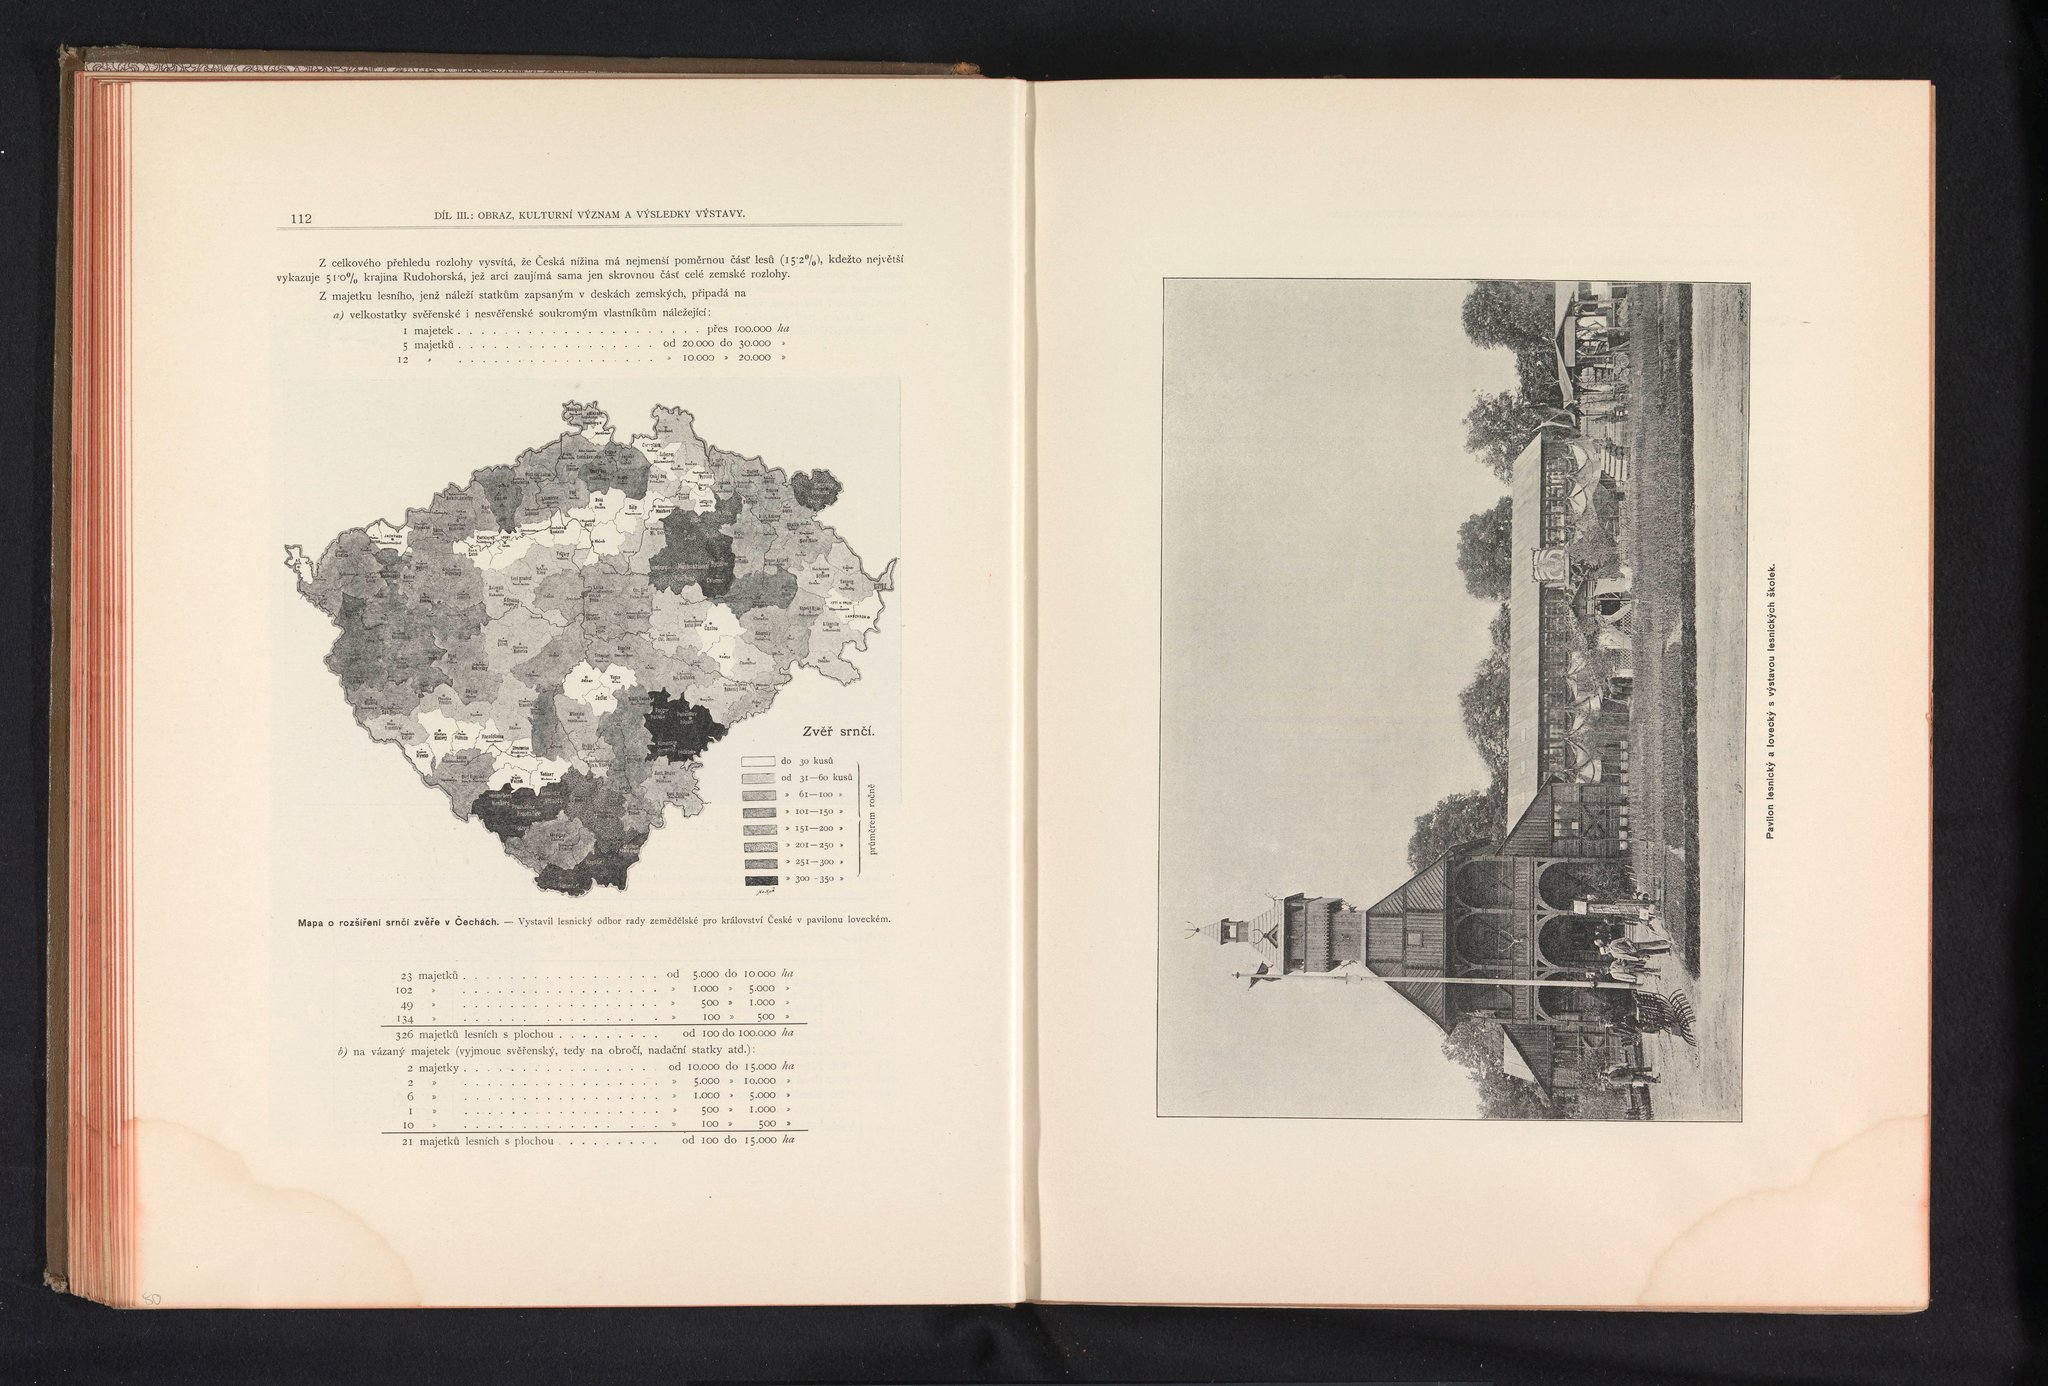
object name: page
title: Pavilon lesnický a lovecký s výstavou lesnických skolek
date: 1891-1895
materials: paper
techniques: autotype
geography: prague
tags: (annual) fair, trade fair, façade (of house or building)